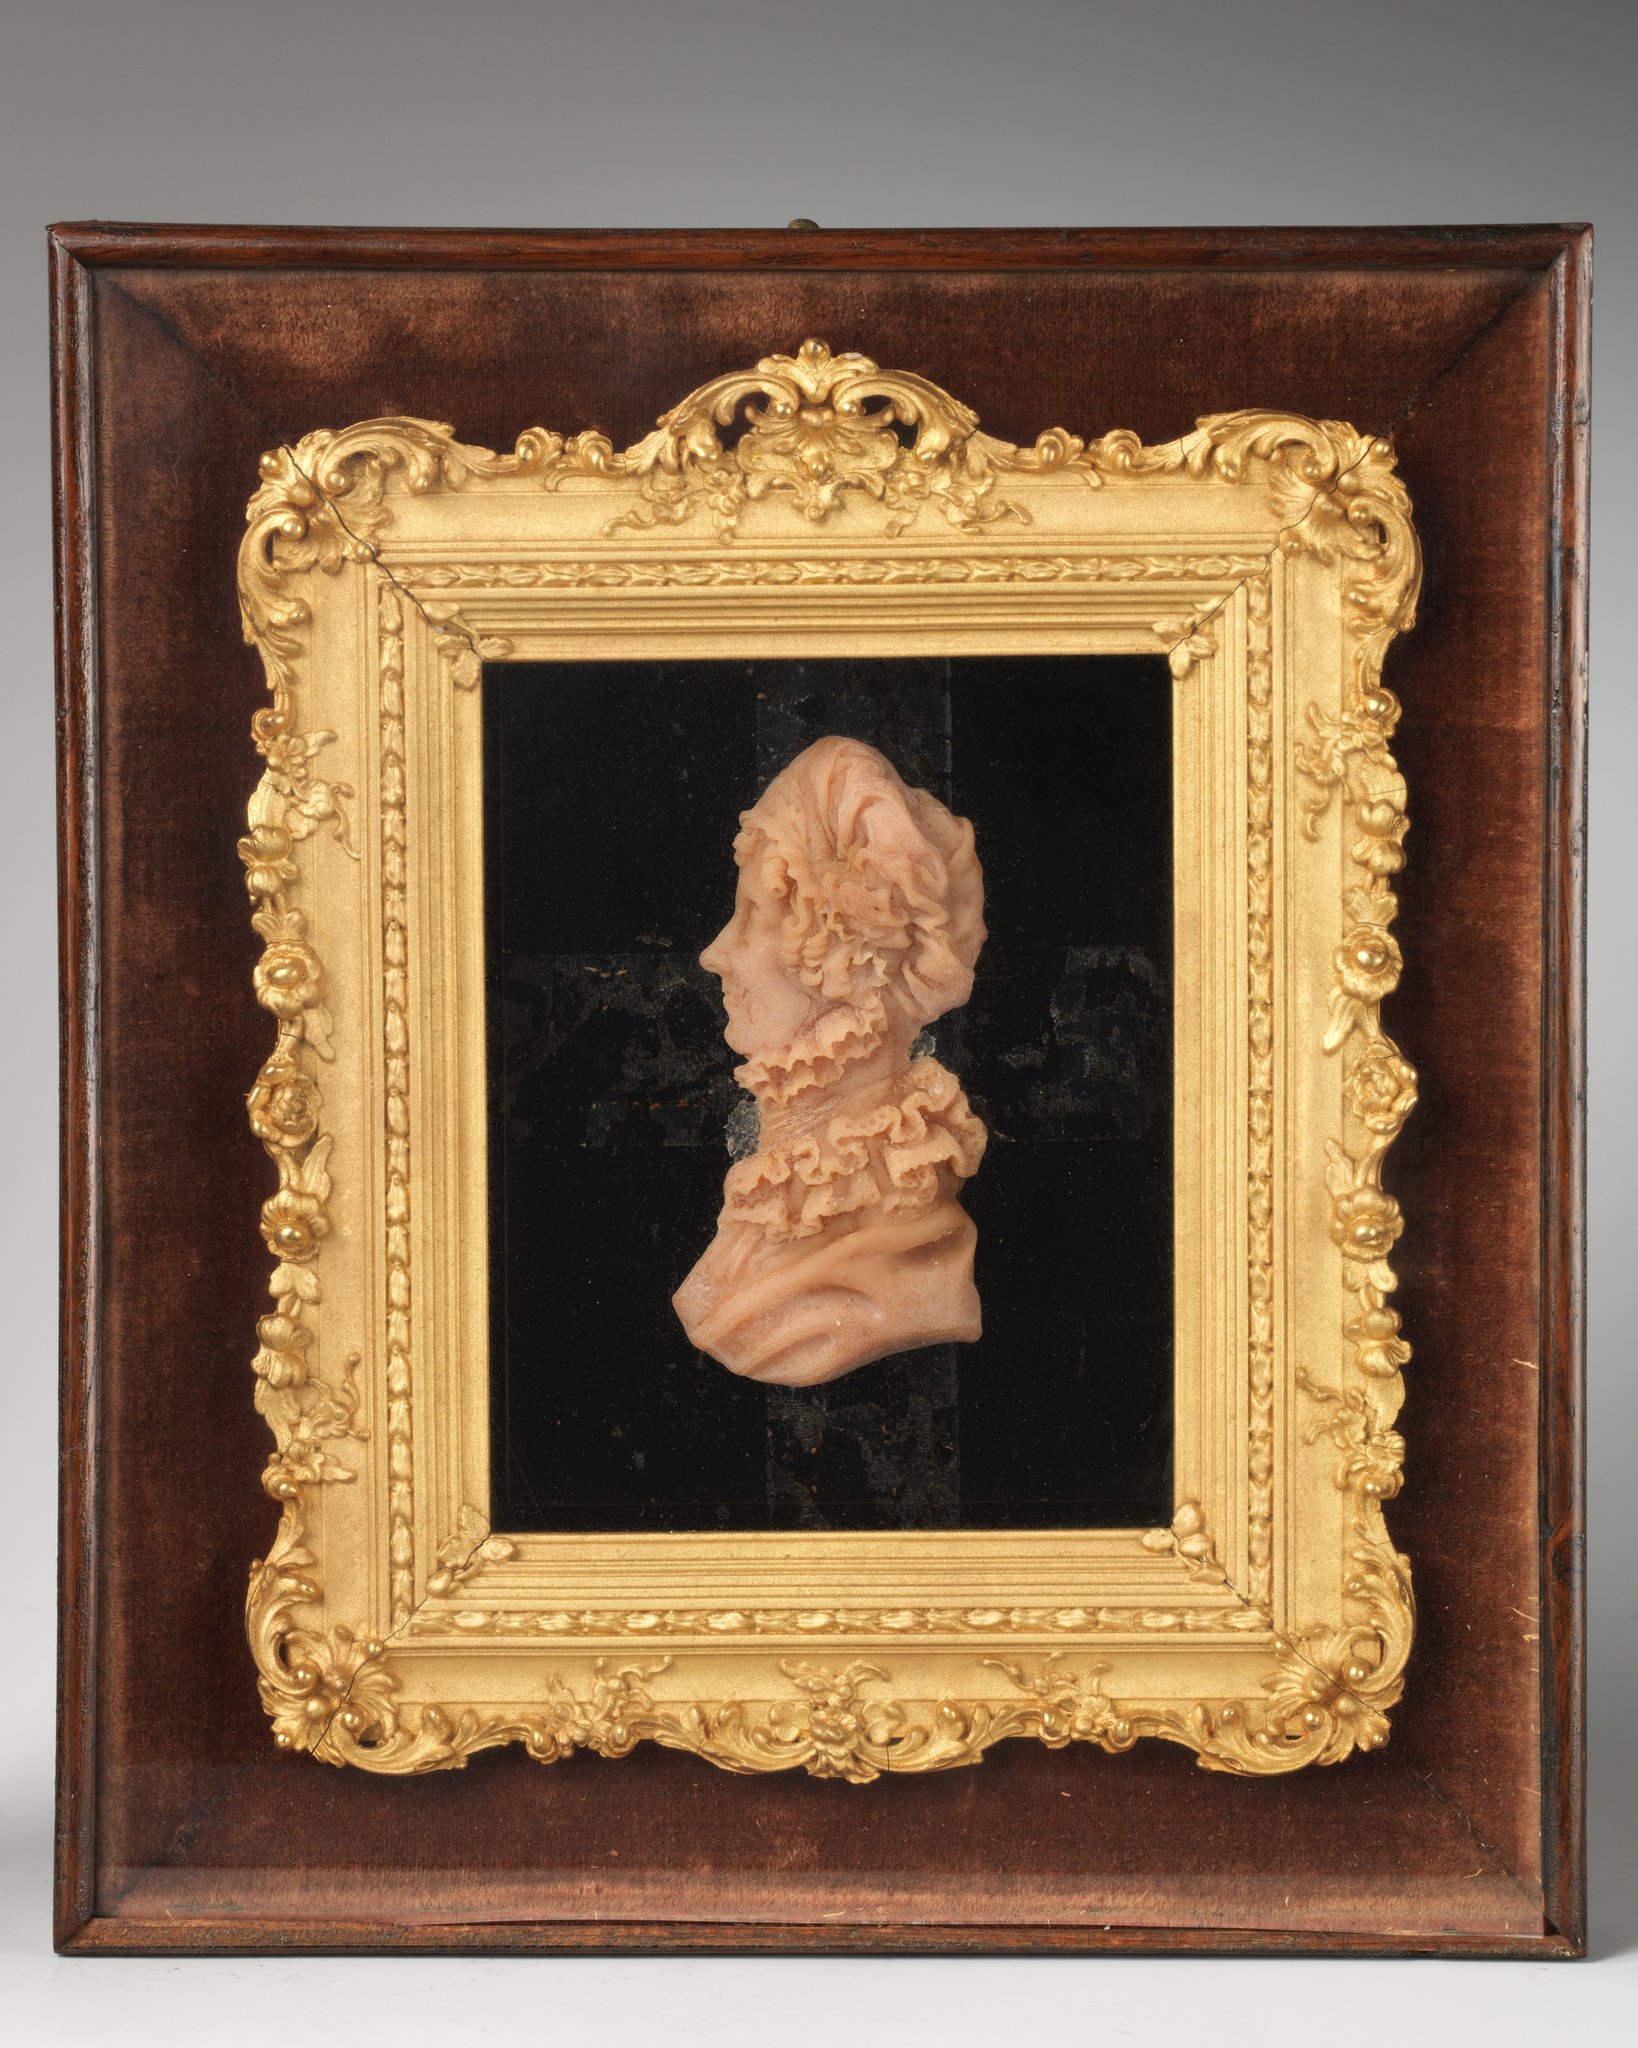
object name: medallion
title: Mrs. Mary Chatham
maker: t. r. poole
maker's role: artist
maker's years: 1721-1821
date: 1801-1900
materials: glass, gold, velvet, wax, wood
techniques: painting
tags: profiles,women